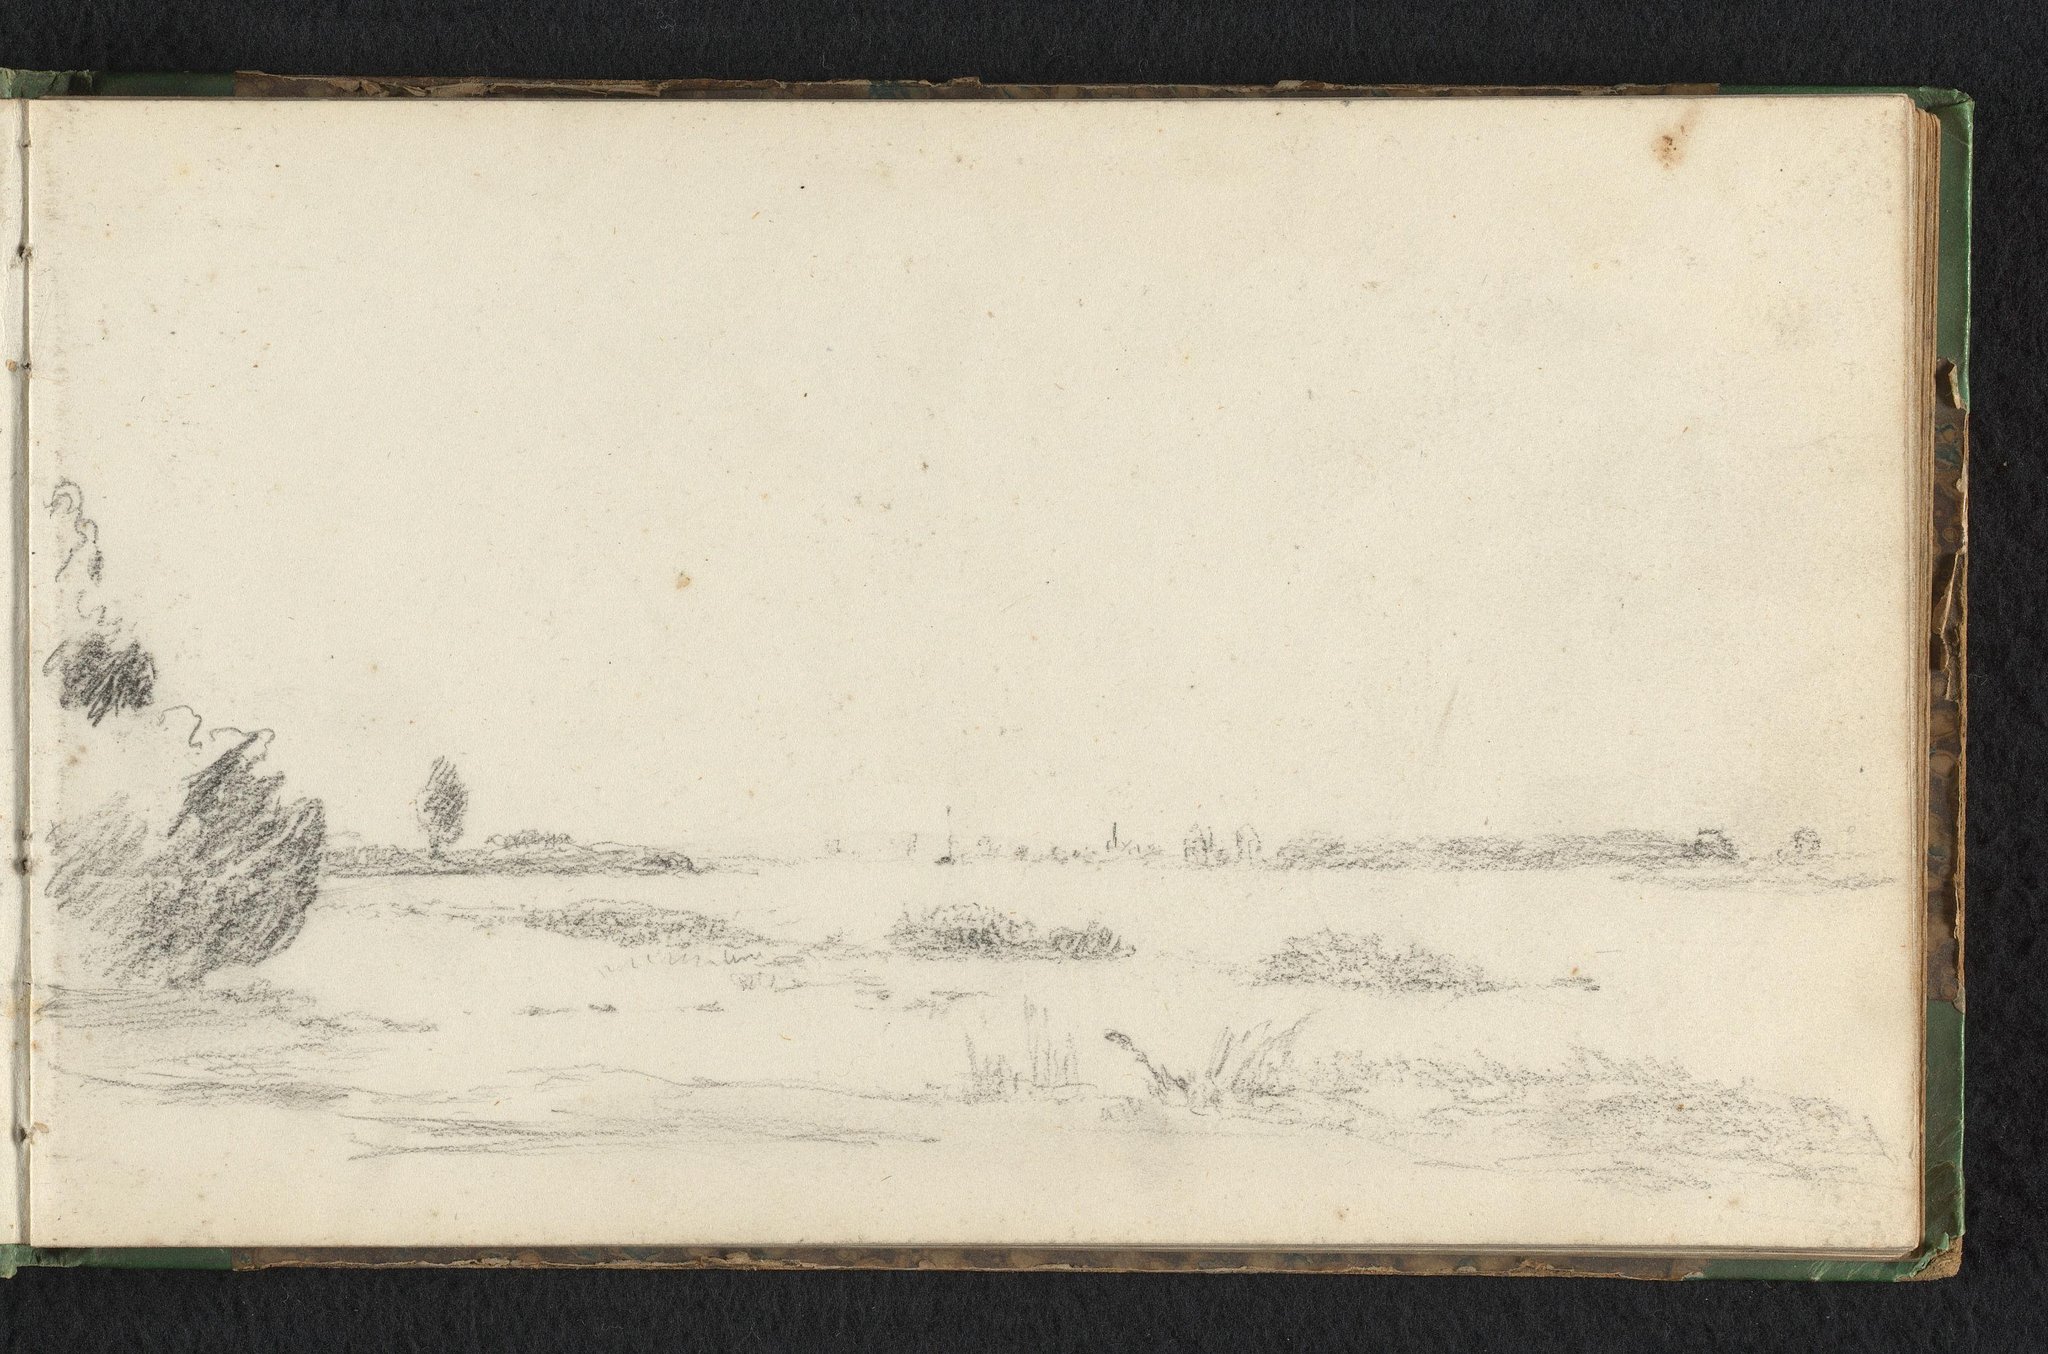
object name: sketchbook leaf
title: Landschap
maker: jan bedijs tom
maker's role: draughtsman, painter, print maker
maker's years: 1813-1894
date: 1823-1894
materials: paper, pencil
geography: the hague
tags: landscapes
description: Pagina 61 verso uit een schetsboek met 61 bladen.